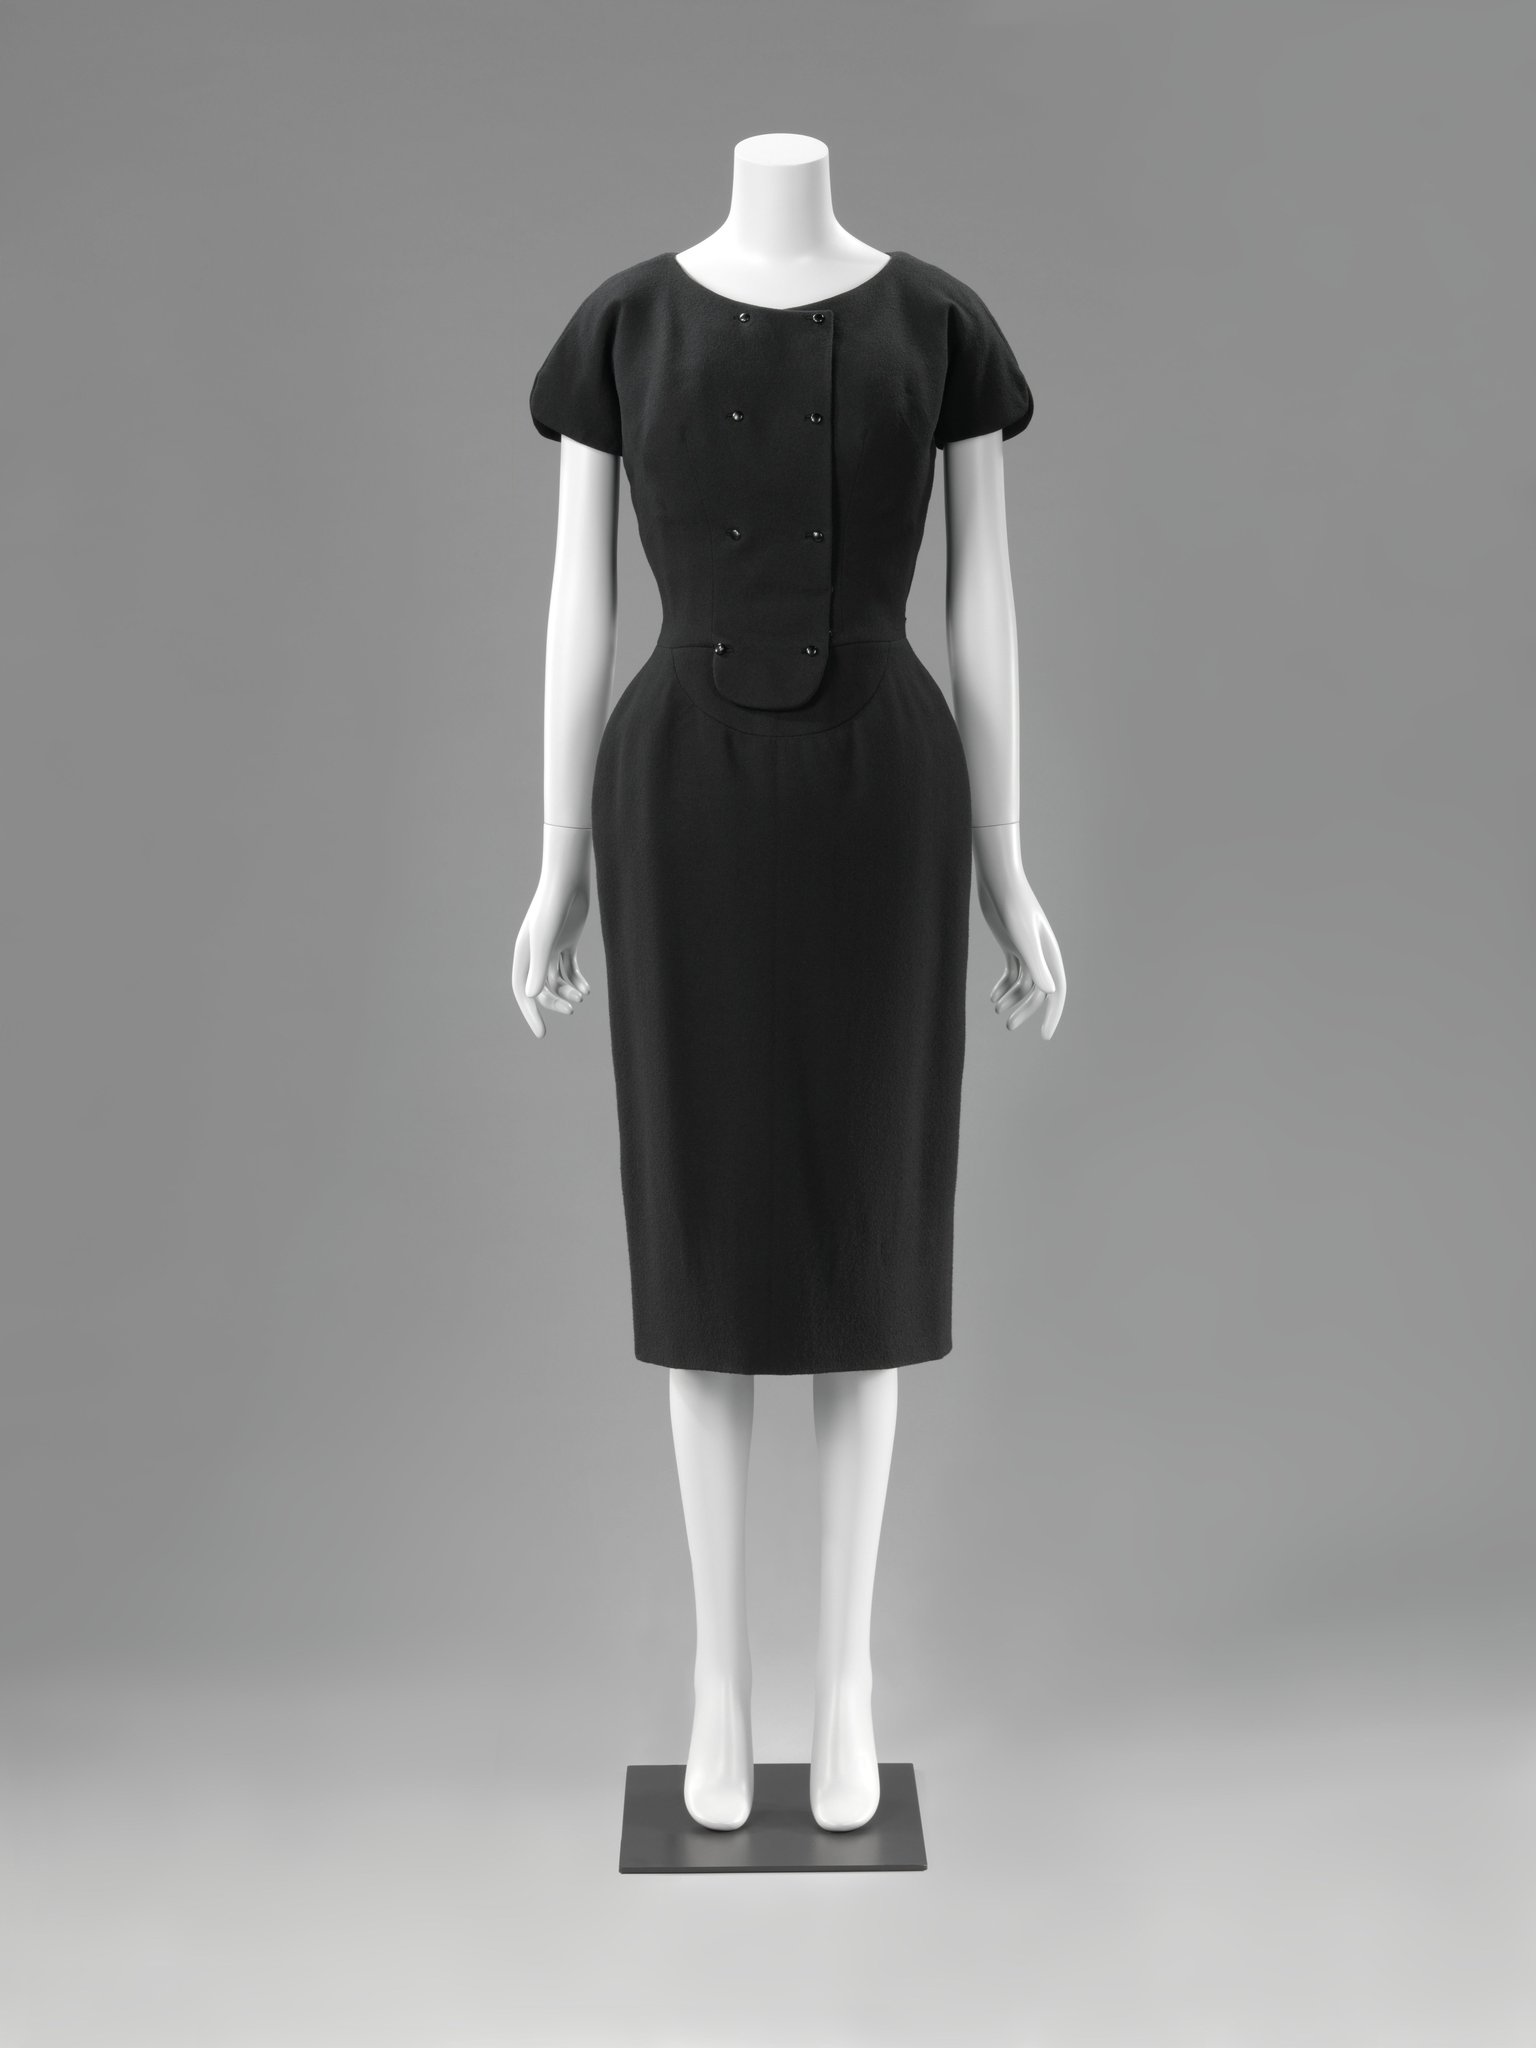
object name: womenswear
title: Dress and Jacket (complet)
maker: catharina kruysveldt-de mare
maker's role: licensee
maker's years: 1874-1956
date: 1952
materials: textile, wool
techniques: weave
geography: amsterdam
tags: amsterdam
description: Christian Dior launched the ‘New Look’ in 1947, with pronounced female forms as its distinguishing feature. The hourglass figure is quite distinct here. The nipped-in waist is accentuated by slit pockets at the hips and a tapered placement of the buttons. Mrs Brusse also chose the ensemble because of its name: Urtebise, her maiden name.